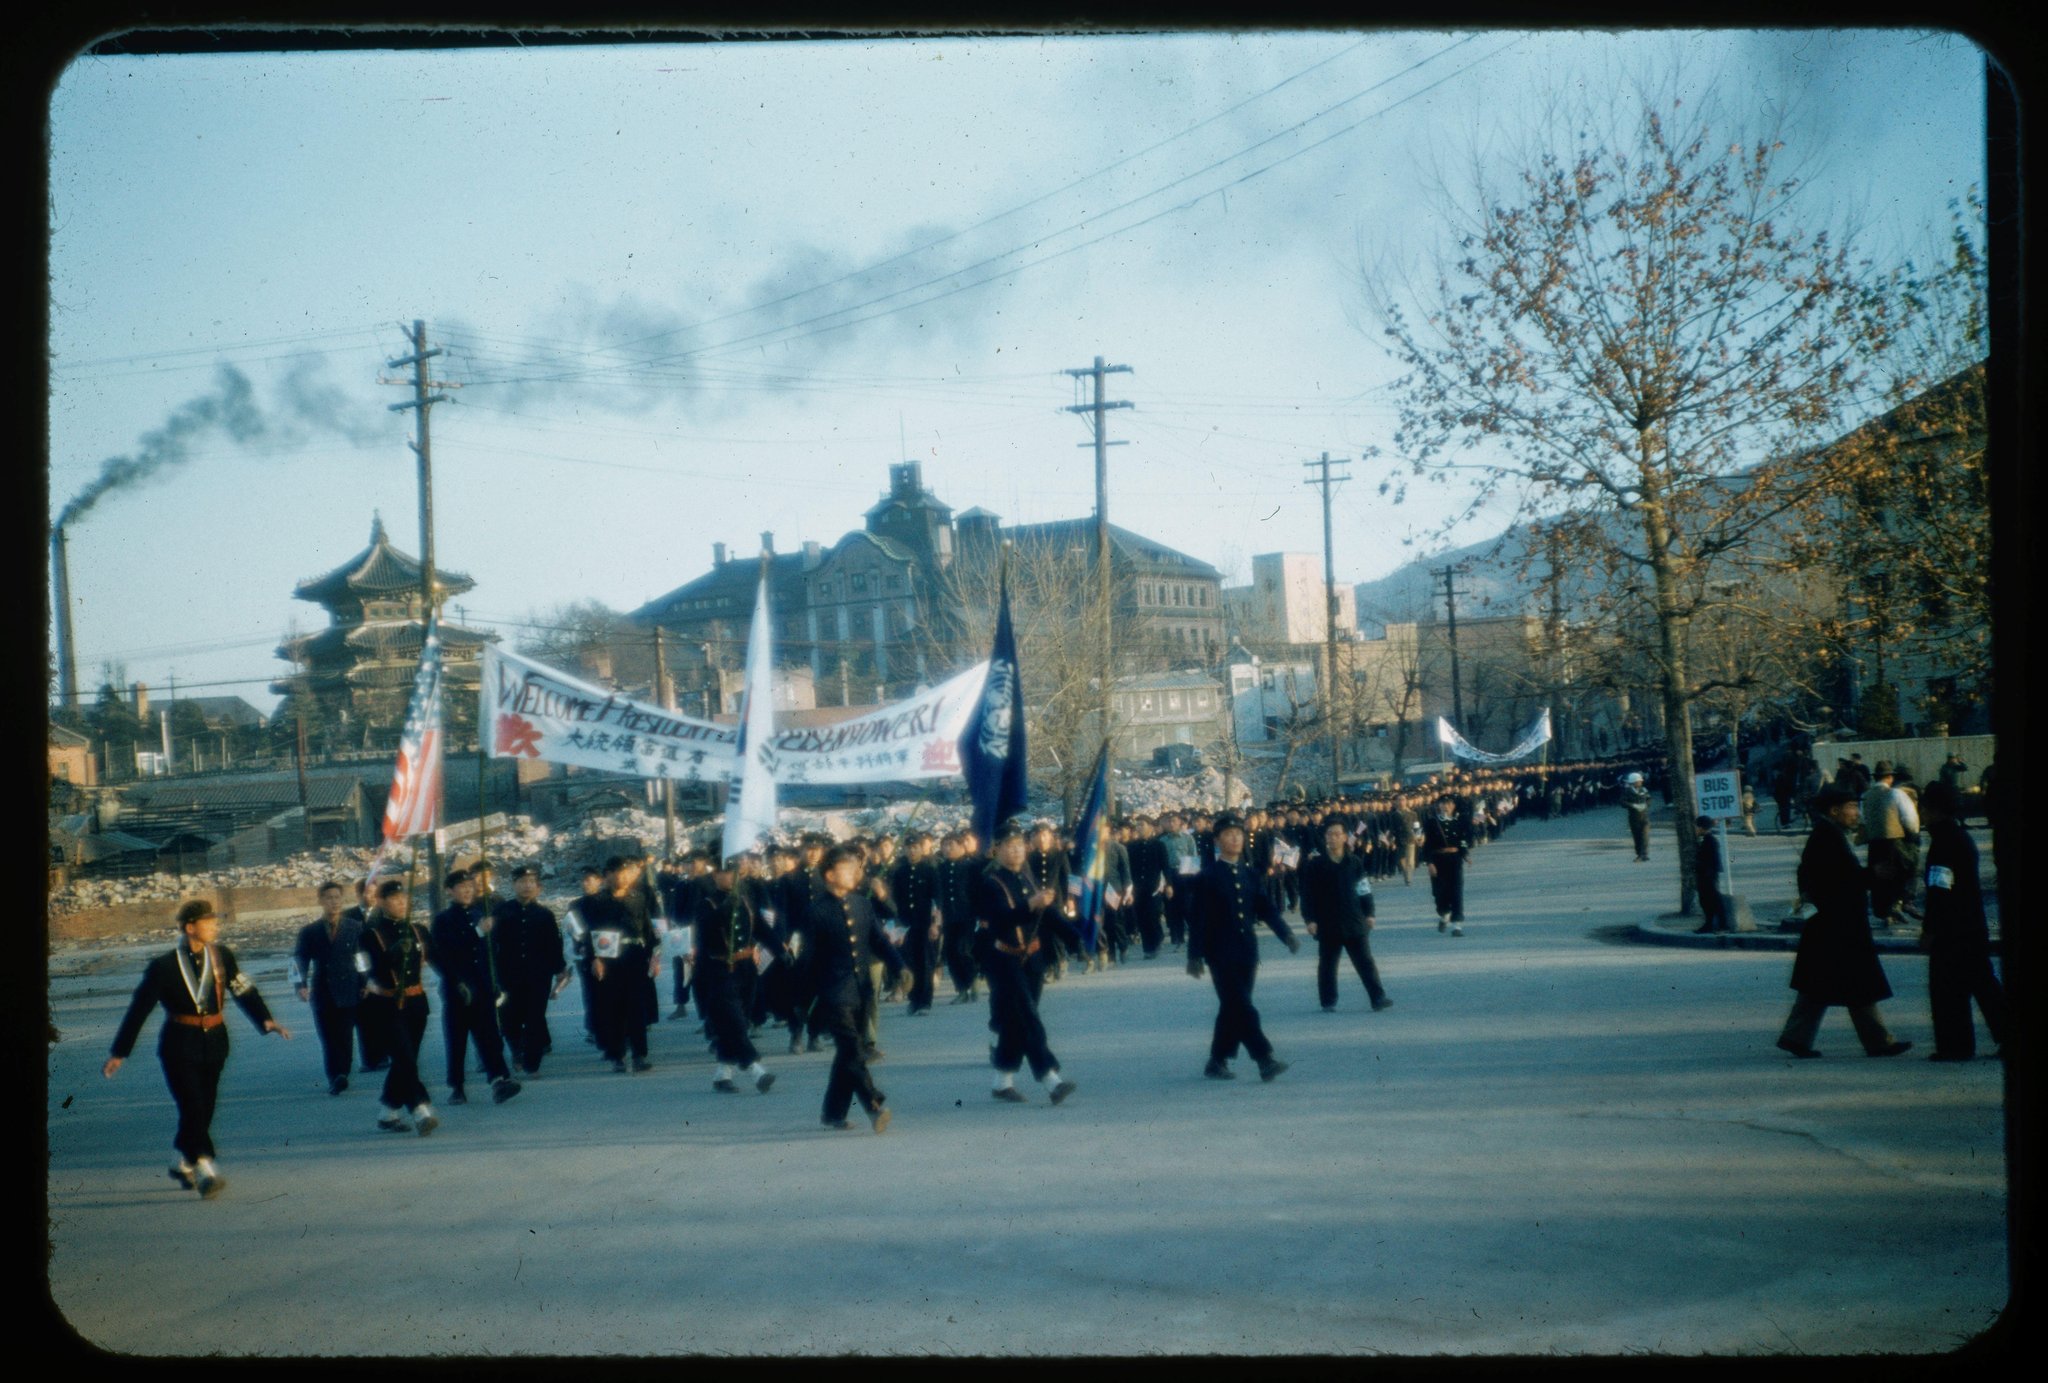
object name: color slide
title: Seoul tijdens het bezoek van Eisenhower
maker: david ketel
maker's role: diplomaat, sinoloog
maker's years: 1913-2008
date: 1912-1952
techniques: slide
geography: korea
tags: united nations